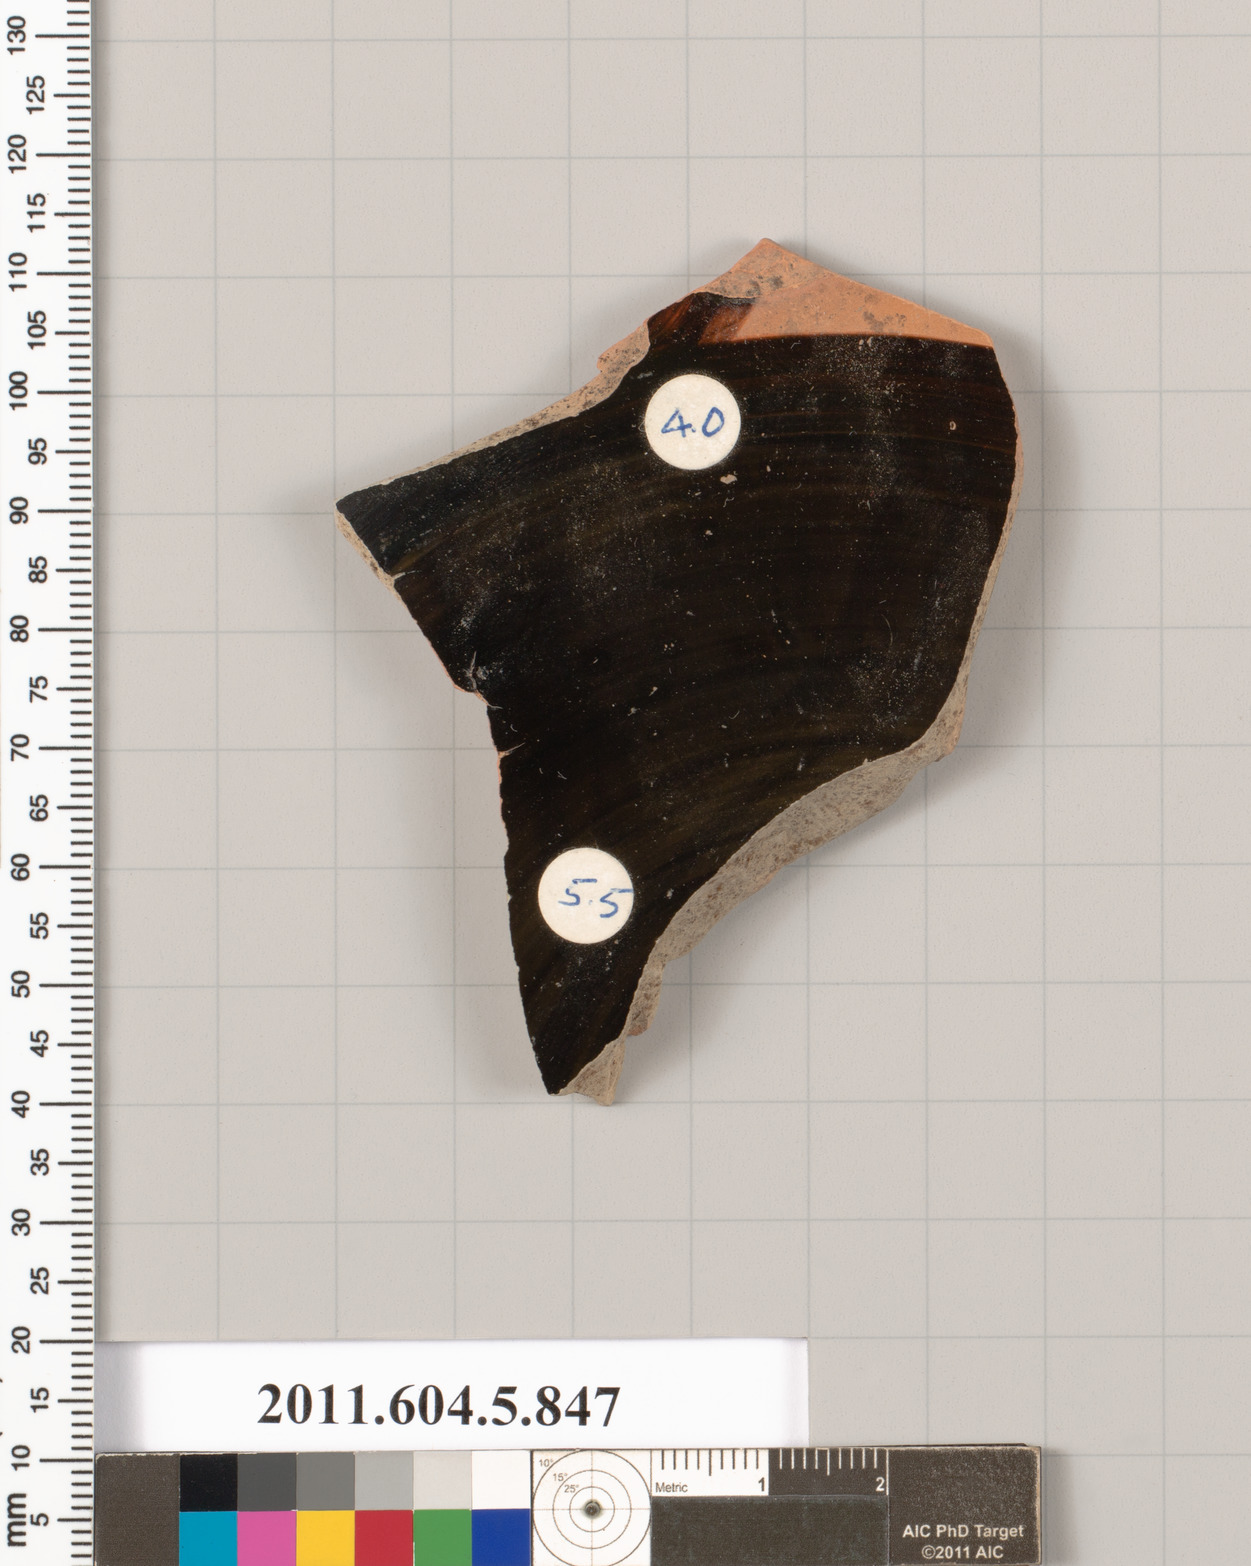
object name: kylix fragment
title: Terracotta fragment of a kylix (drinking cup)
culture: greek, attic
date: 600-401 BCE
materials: terracotta